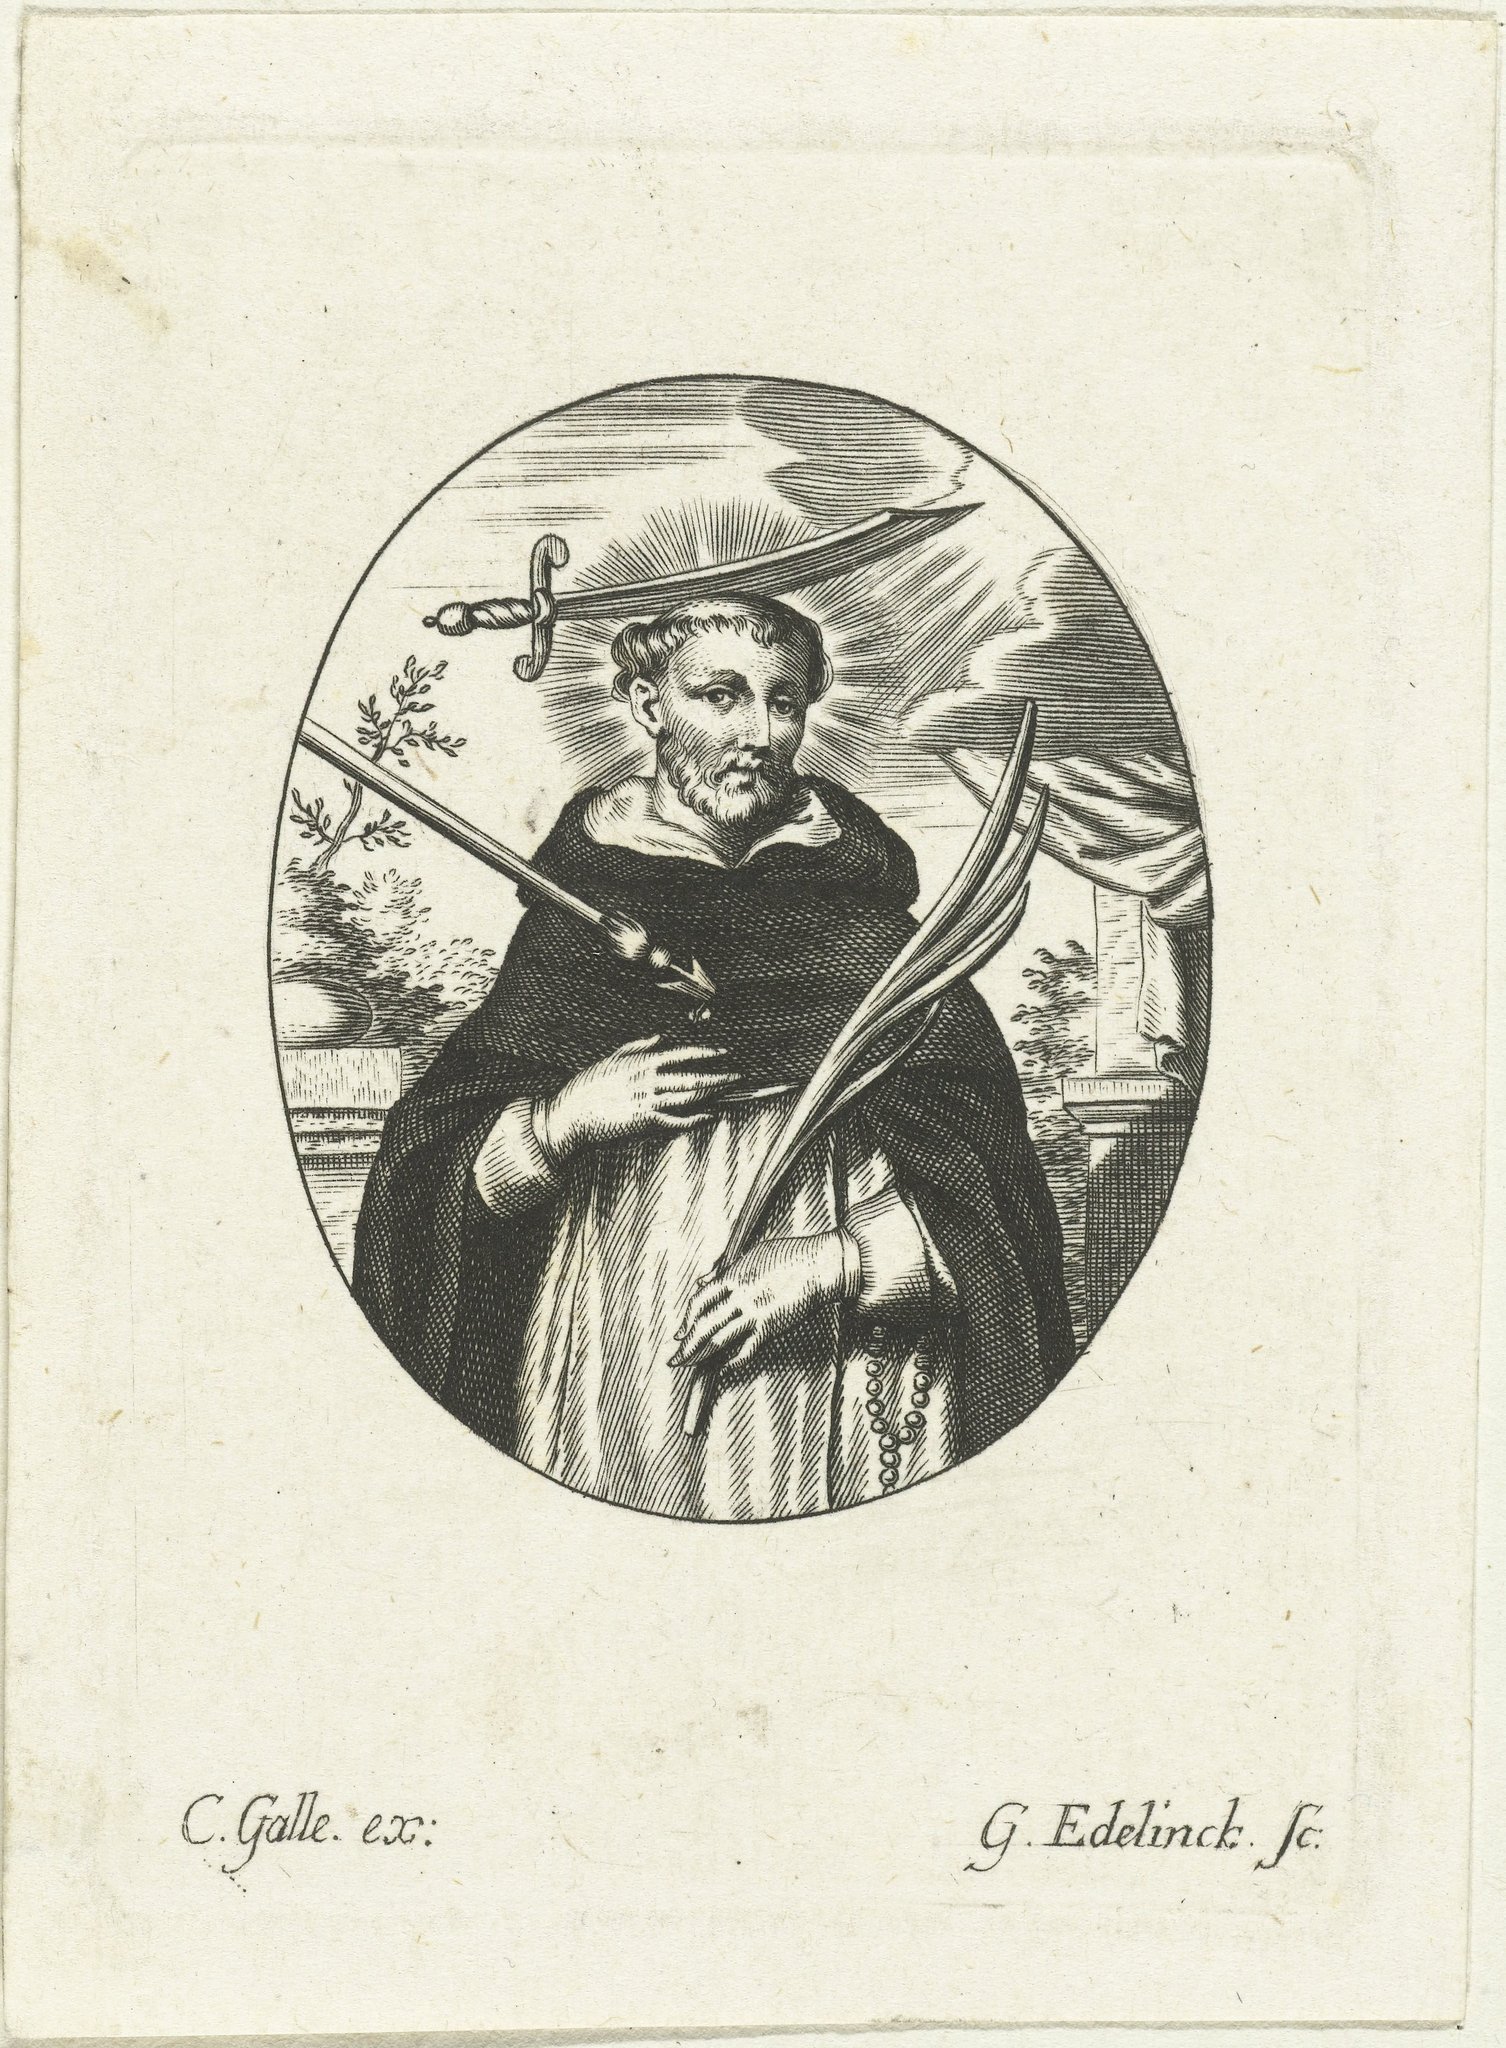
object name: print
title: Petrus Martyr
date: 1652-1666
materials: paper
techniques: engraving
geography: antwerp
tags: the dominican friar peter martyr of verona; possible attributes: crucifix, finger at lips, palm, sword (axe or knife) in skull (or breast), wound in head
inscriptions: collector's mark: Lugt 240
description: Portret ten halven lijve van de martelaar Petrus Martyr, afgebeeld met palmtak, zwaard op zijn schedel en speer in de borst.